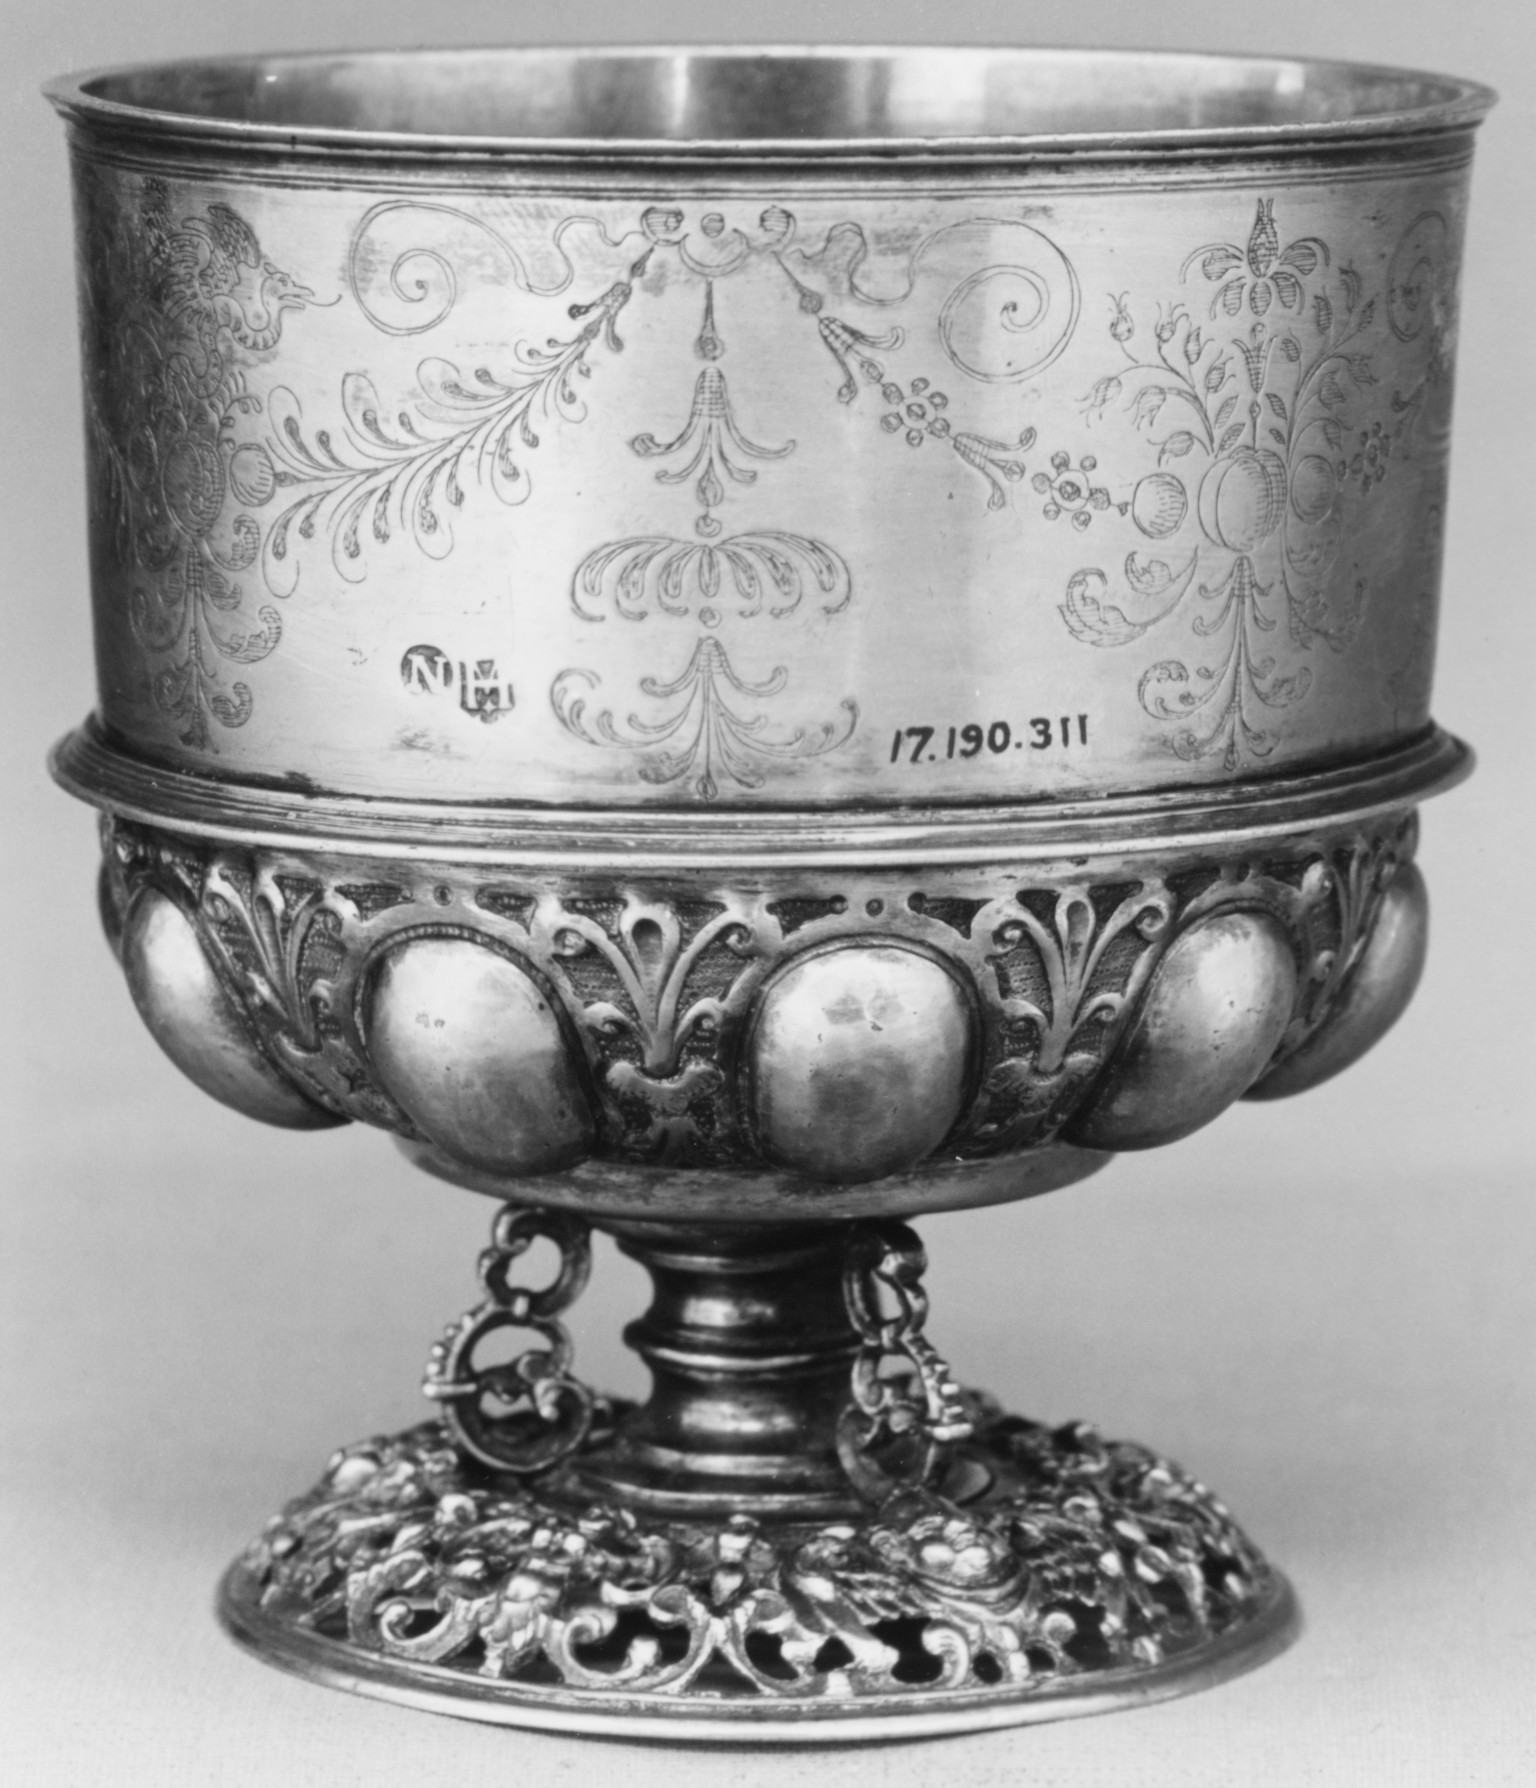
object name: cup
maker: heinrich mack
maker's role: maker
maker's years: 1581-1626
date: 1601-1633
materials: silver gilt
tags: snakes